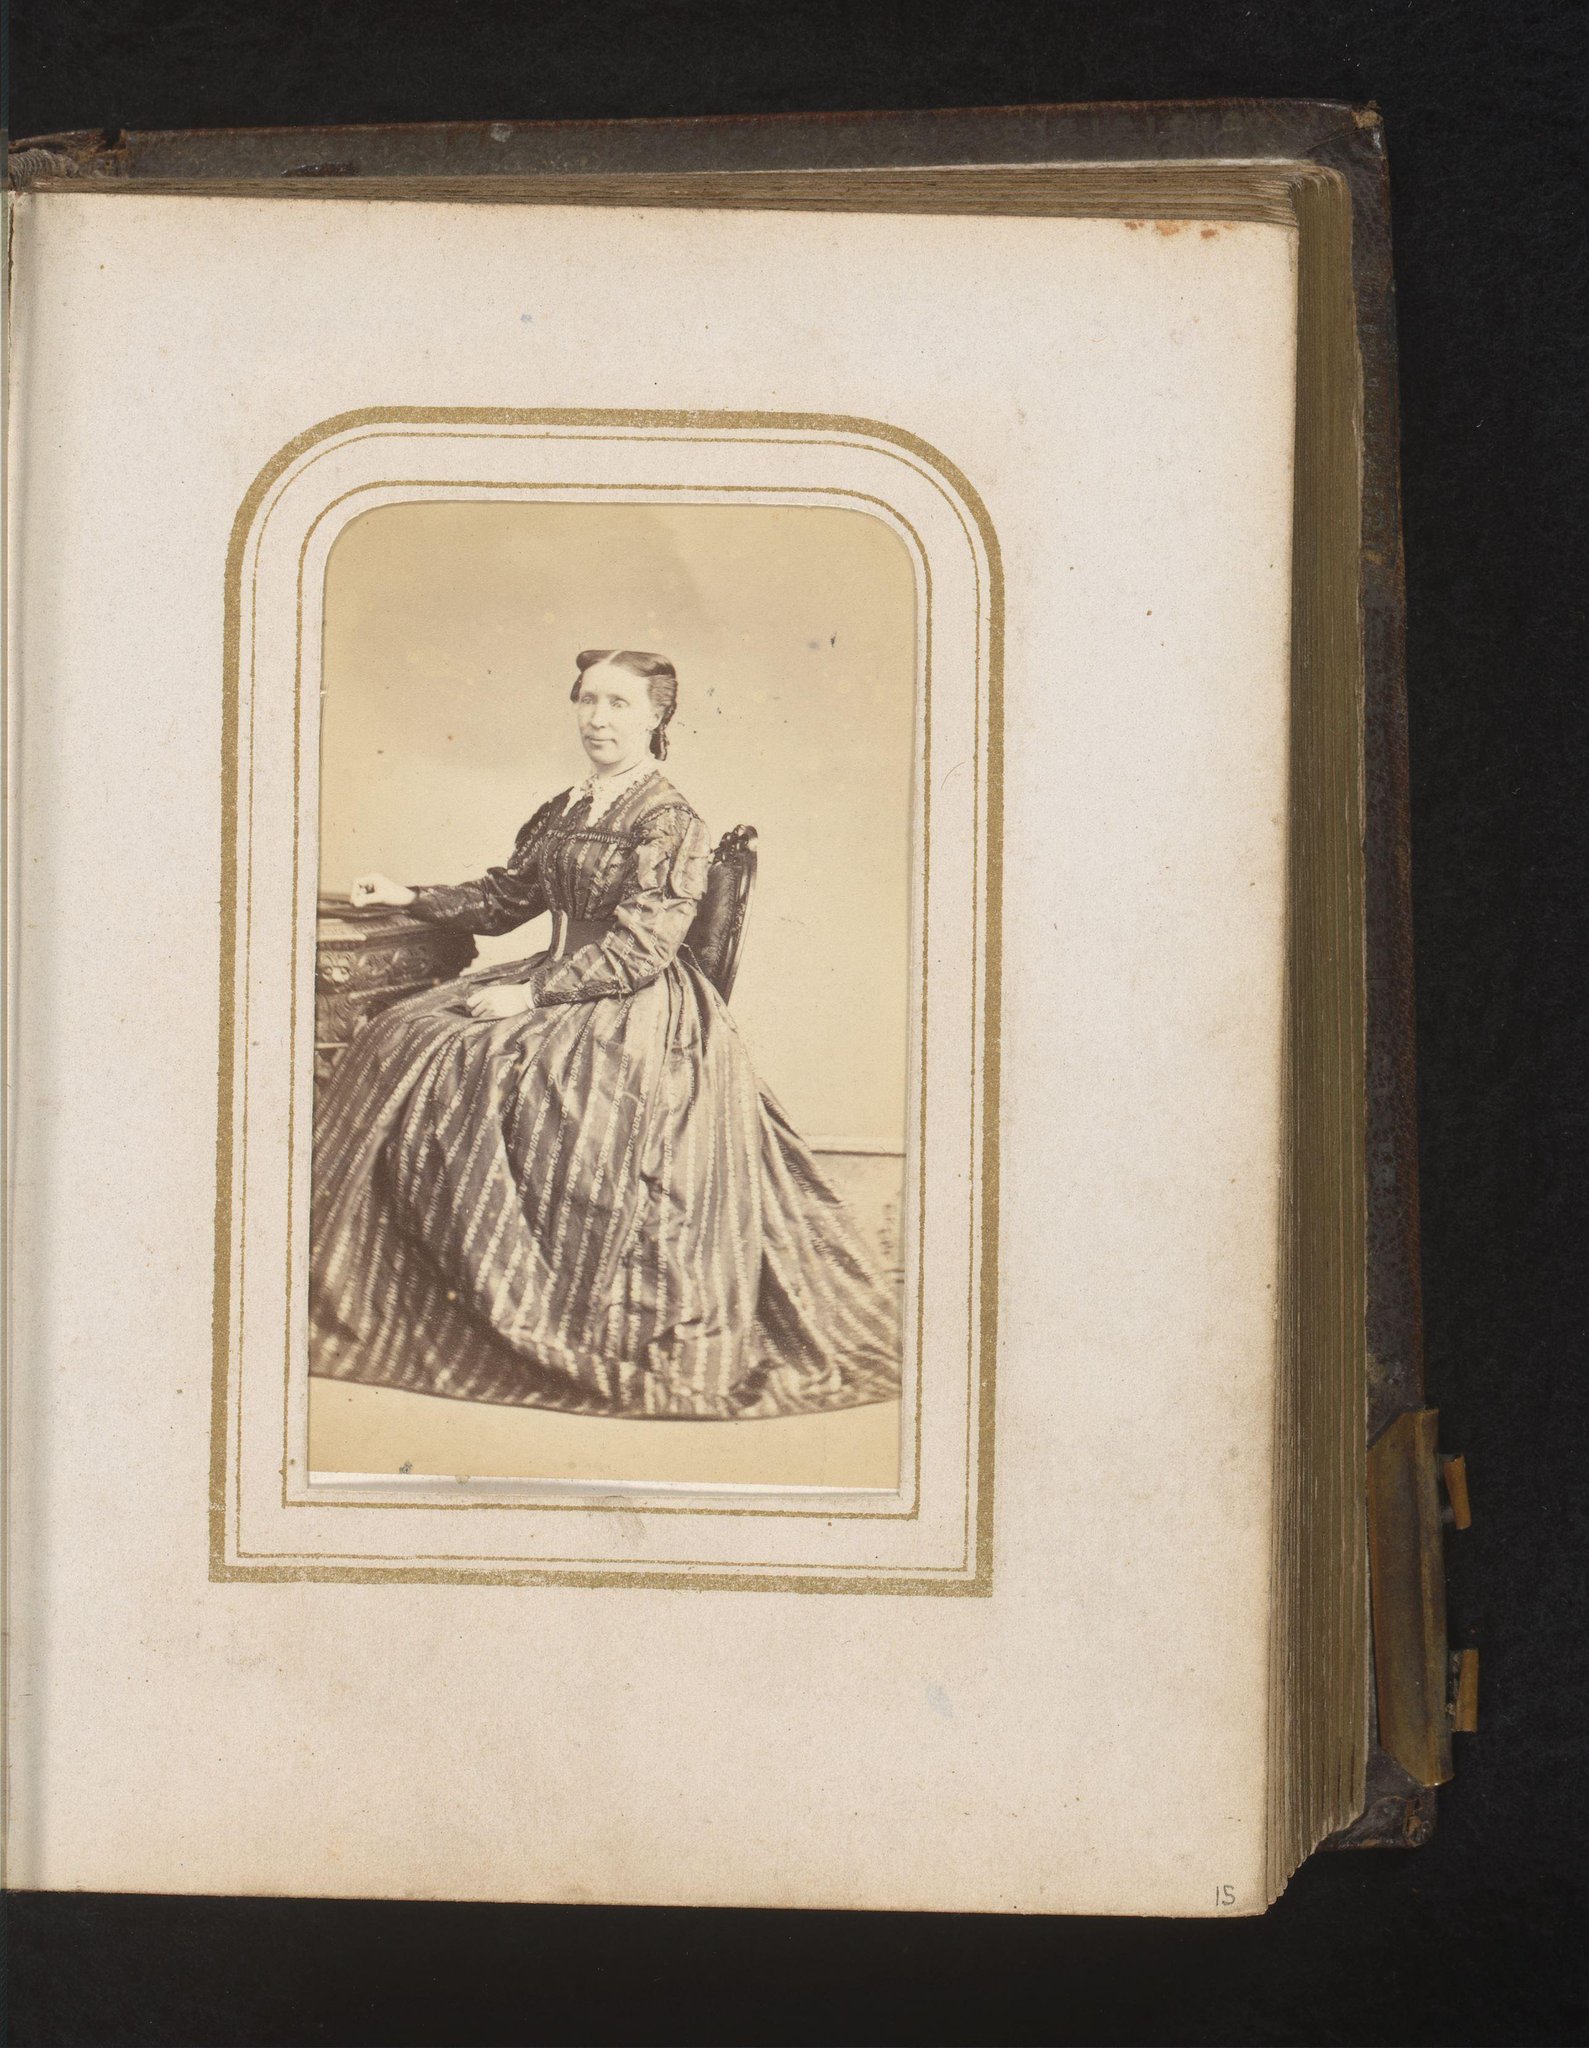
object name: carte de visite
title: Portret van een vrouw, zittend aan een tafel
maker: john horsburgh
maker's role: fotograaf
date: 1860-1890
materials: cardboard, photographic support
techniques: albumen print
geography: edinburgh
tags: sitting figure - aa - female human figure, historical persons - bb - woman, table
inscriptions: inscription: ‘STUDIOS OF FINE ART & PHOTOGRAPHY/ HORSBURGH/ 17, Princes Street/ EDINBURGH/ NEGATIVE PRESERVED/ Life Size Portraits finished in Oil’